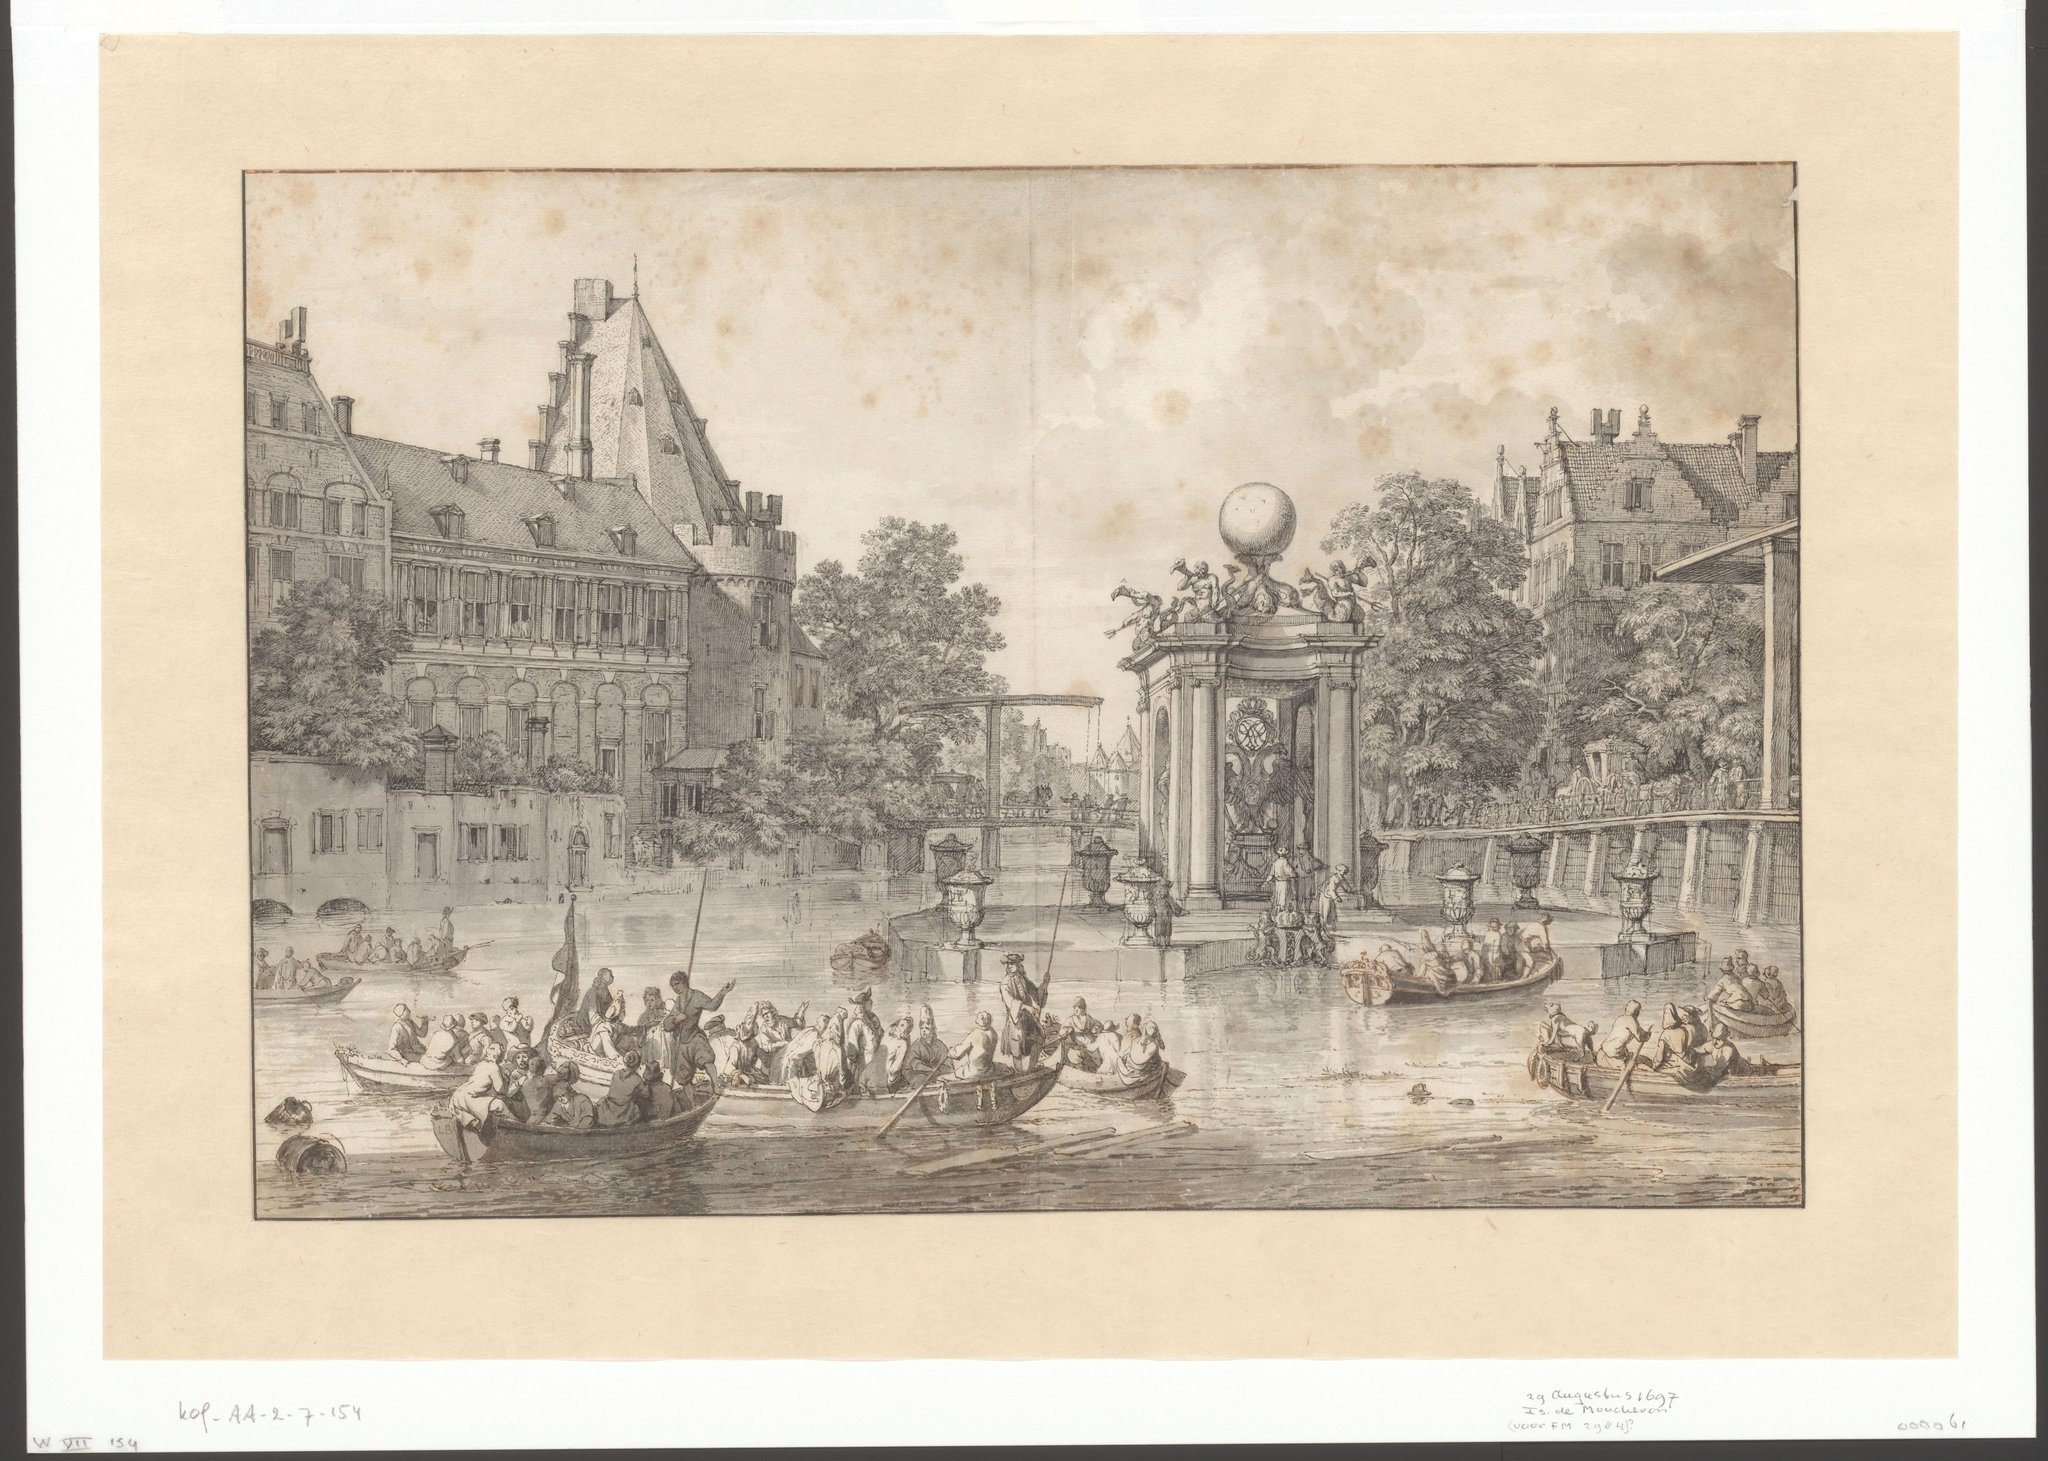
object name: drawing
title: Gezicht op de Amstel en het Rondeel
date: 1677-1708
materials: ink, paper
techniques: brush, pen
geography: amsterdam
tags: sailing-ship, sailing-boat, city-view in general; 'veduta', canal, bridge in city across river, canal, etc., boat propelled by man or animal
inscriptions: collector's mark: Lugt 800a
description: Tekening binnen de Atlas Van Eck ingedeeld op wijknummer 7.